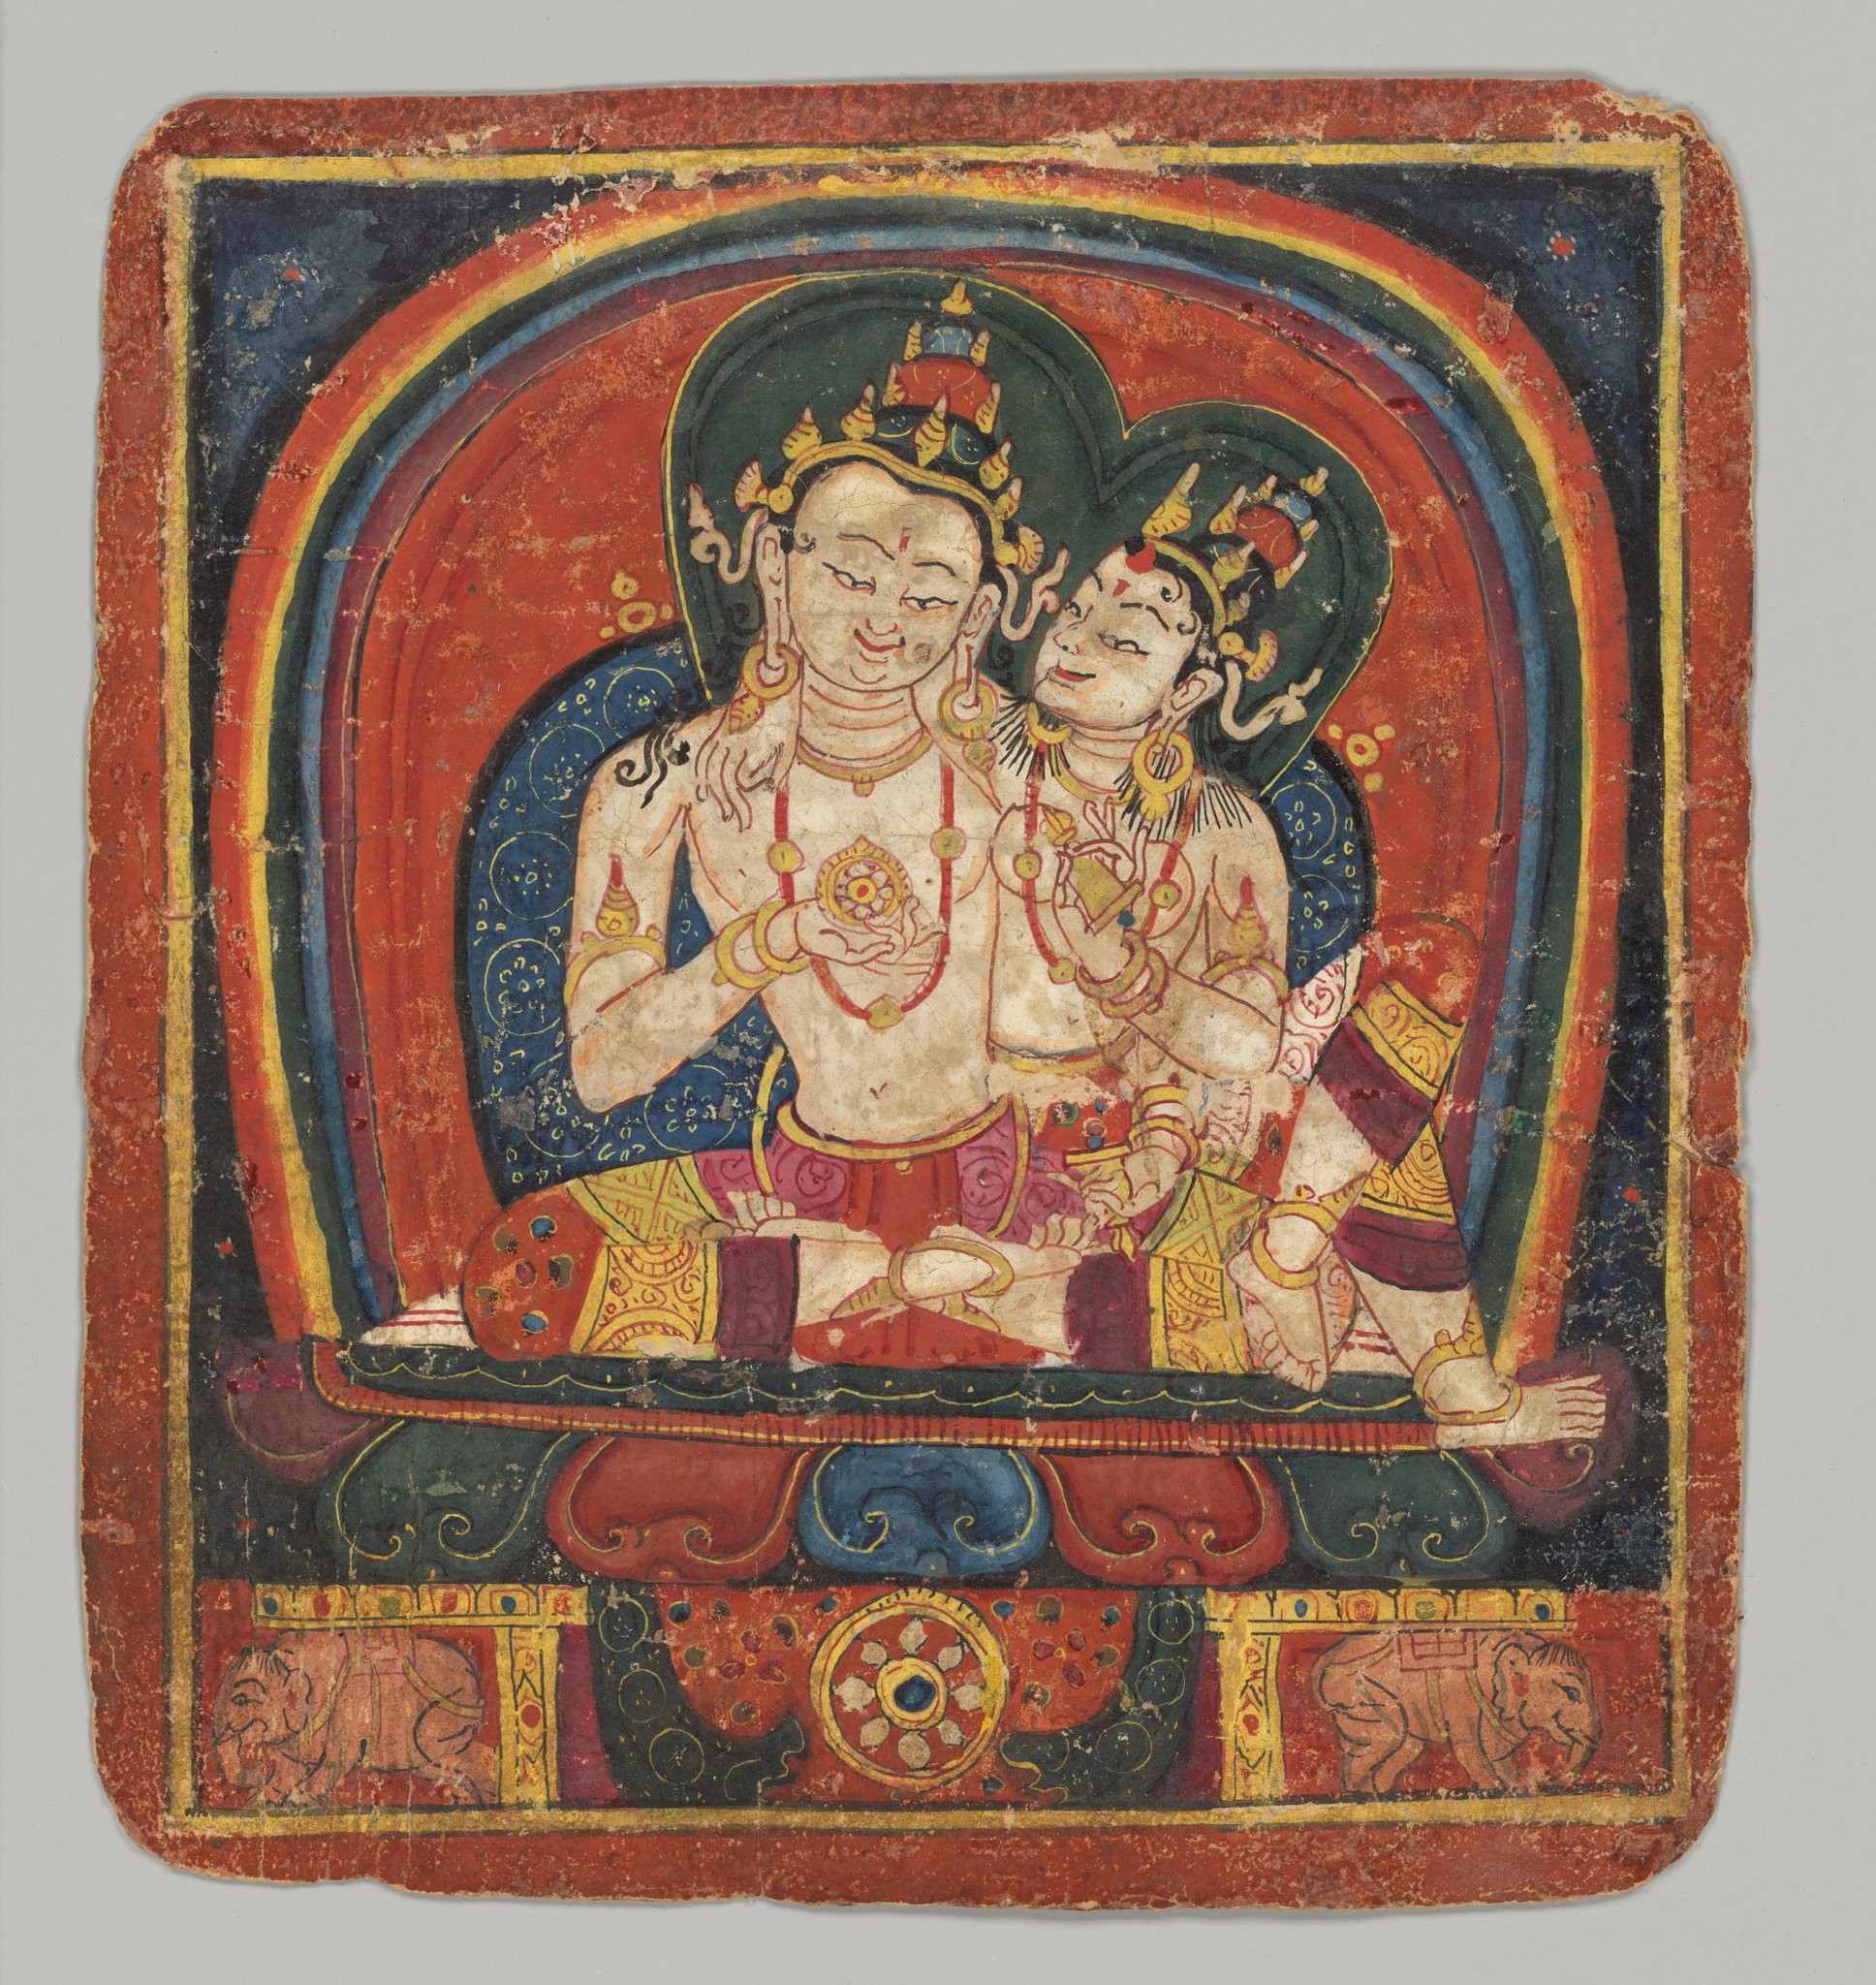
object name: initiation card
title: Initiation Card (Tsakalis): Vairochana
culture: tibetan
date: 1401-1433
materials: paper, watercolor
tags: buddhism